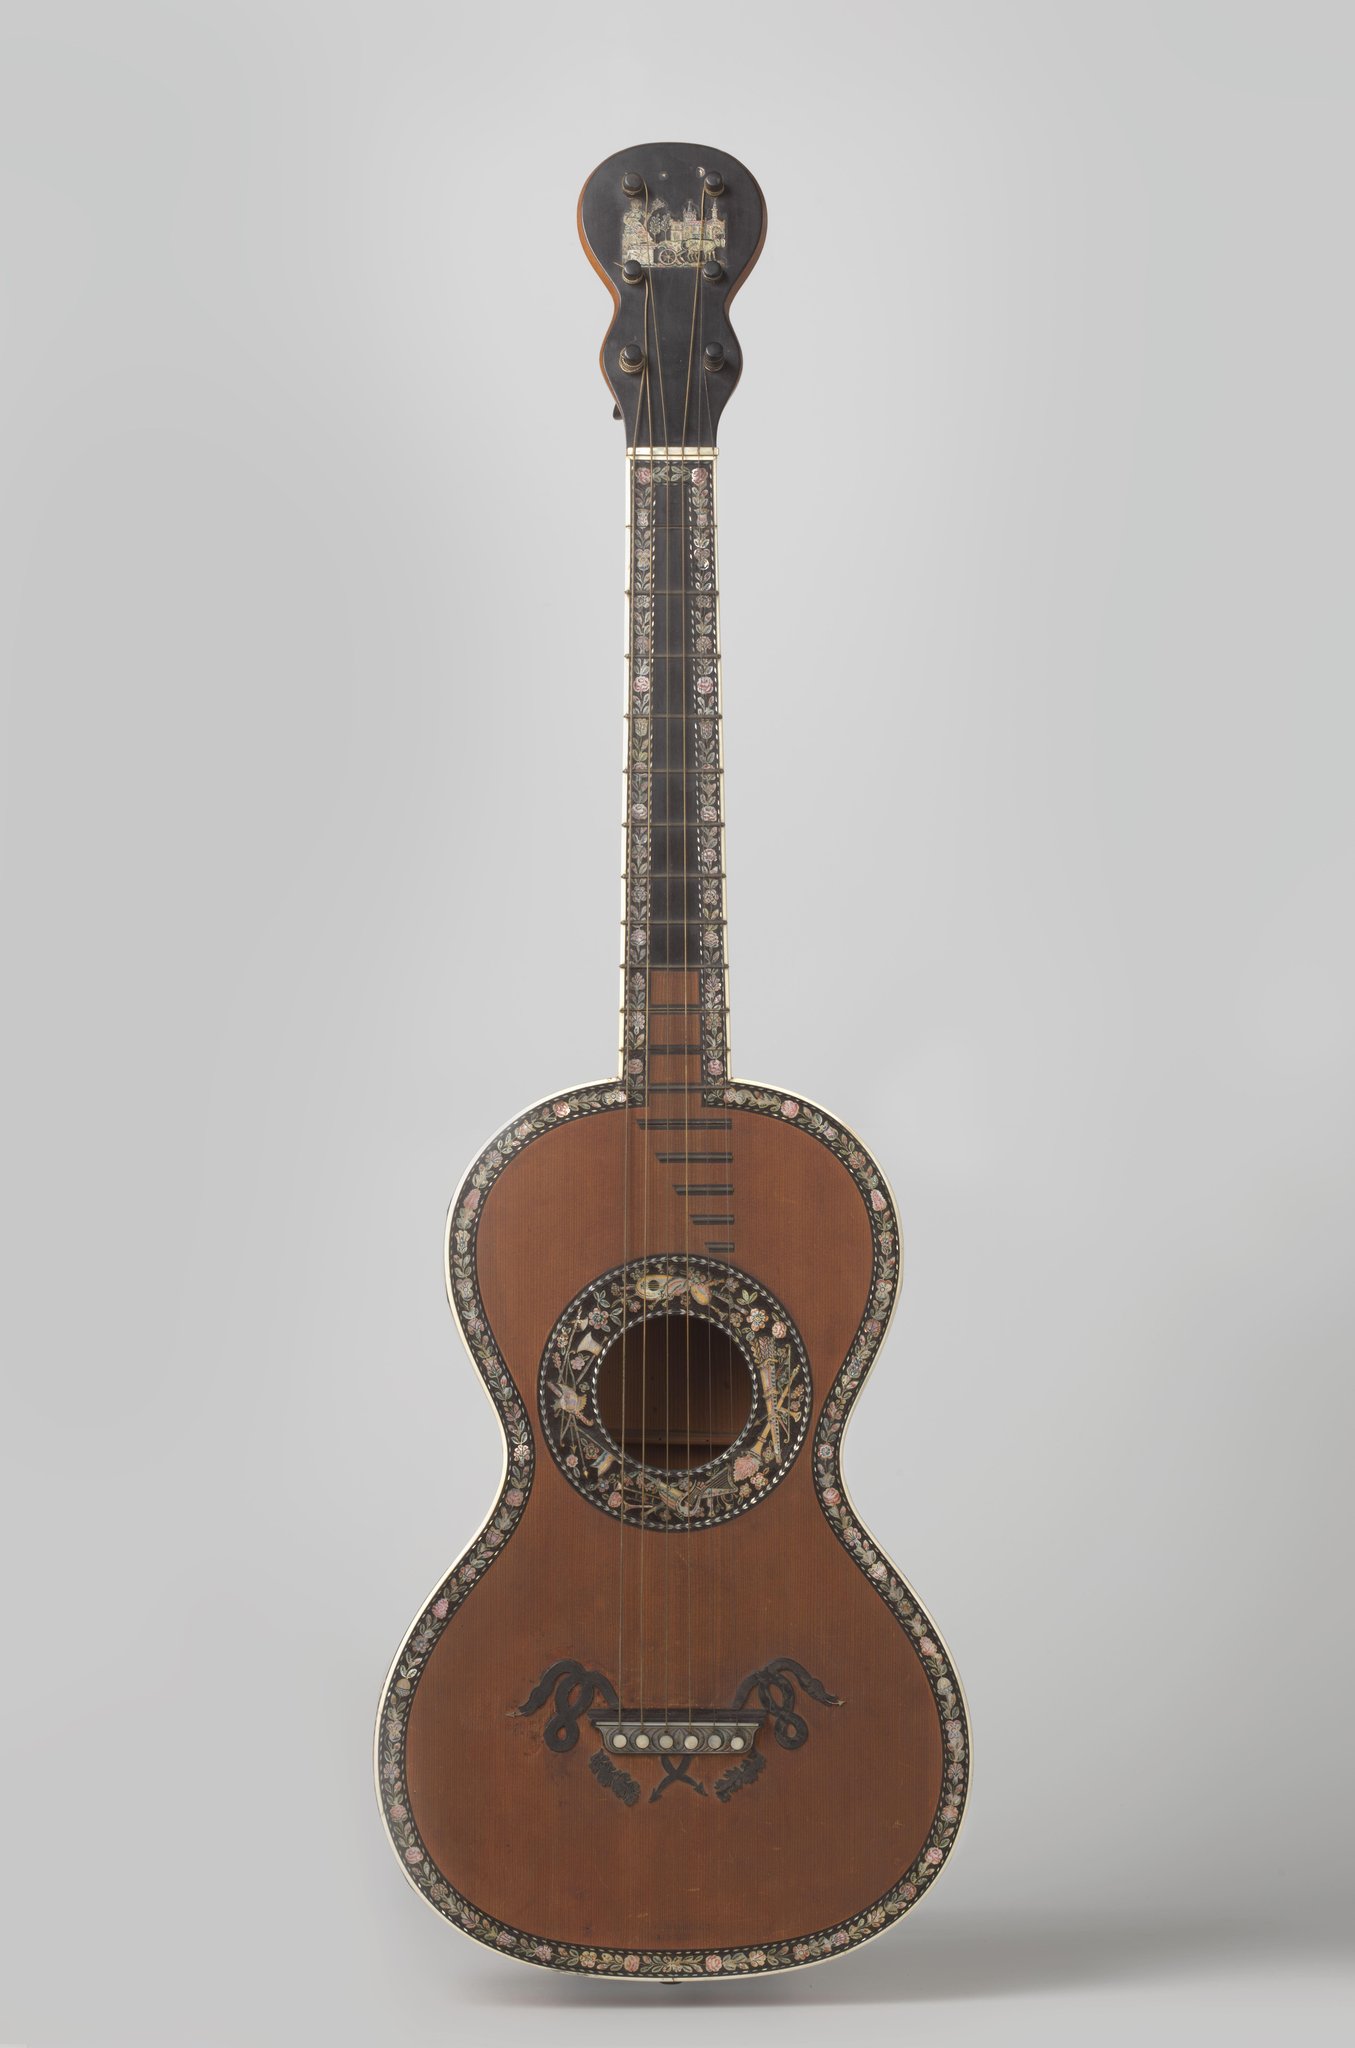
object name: stringed instrument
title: Guitar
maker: m.c. mousset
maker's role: musical instrument maker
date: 1840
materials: wood, ivory, metal, mother of pearl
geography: paris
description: Gitaar met perle d'amour zwart en ivoor ingelegd. De rand der roset is ingelegd met figuren welke allerlei muziekinstrumenten voorstellen.